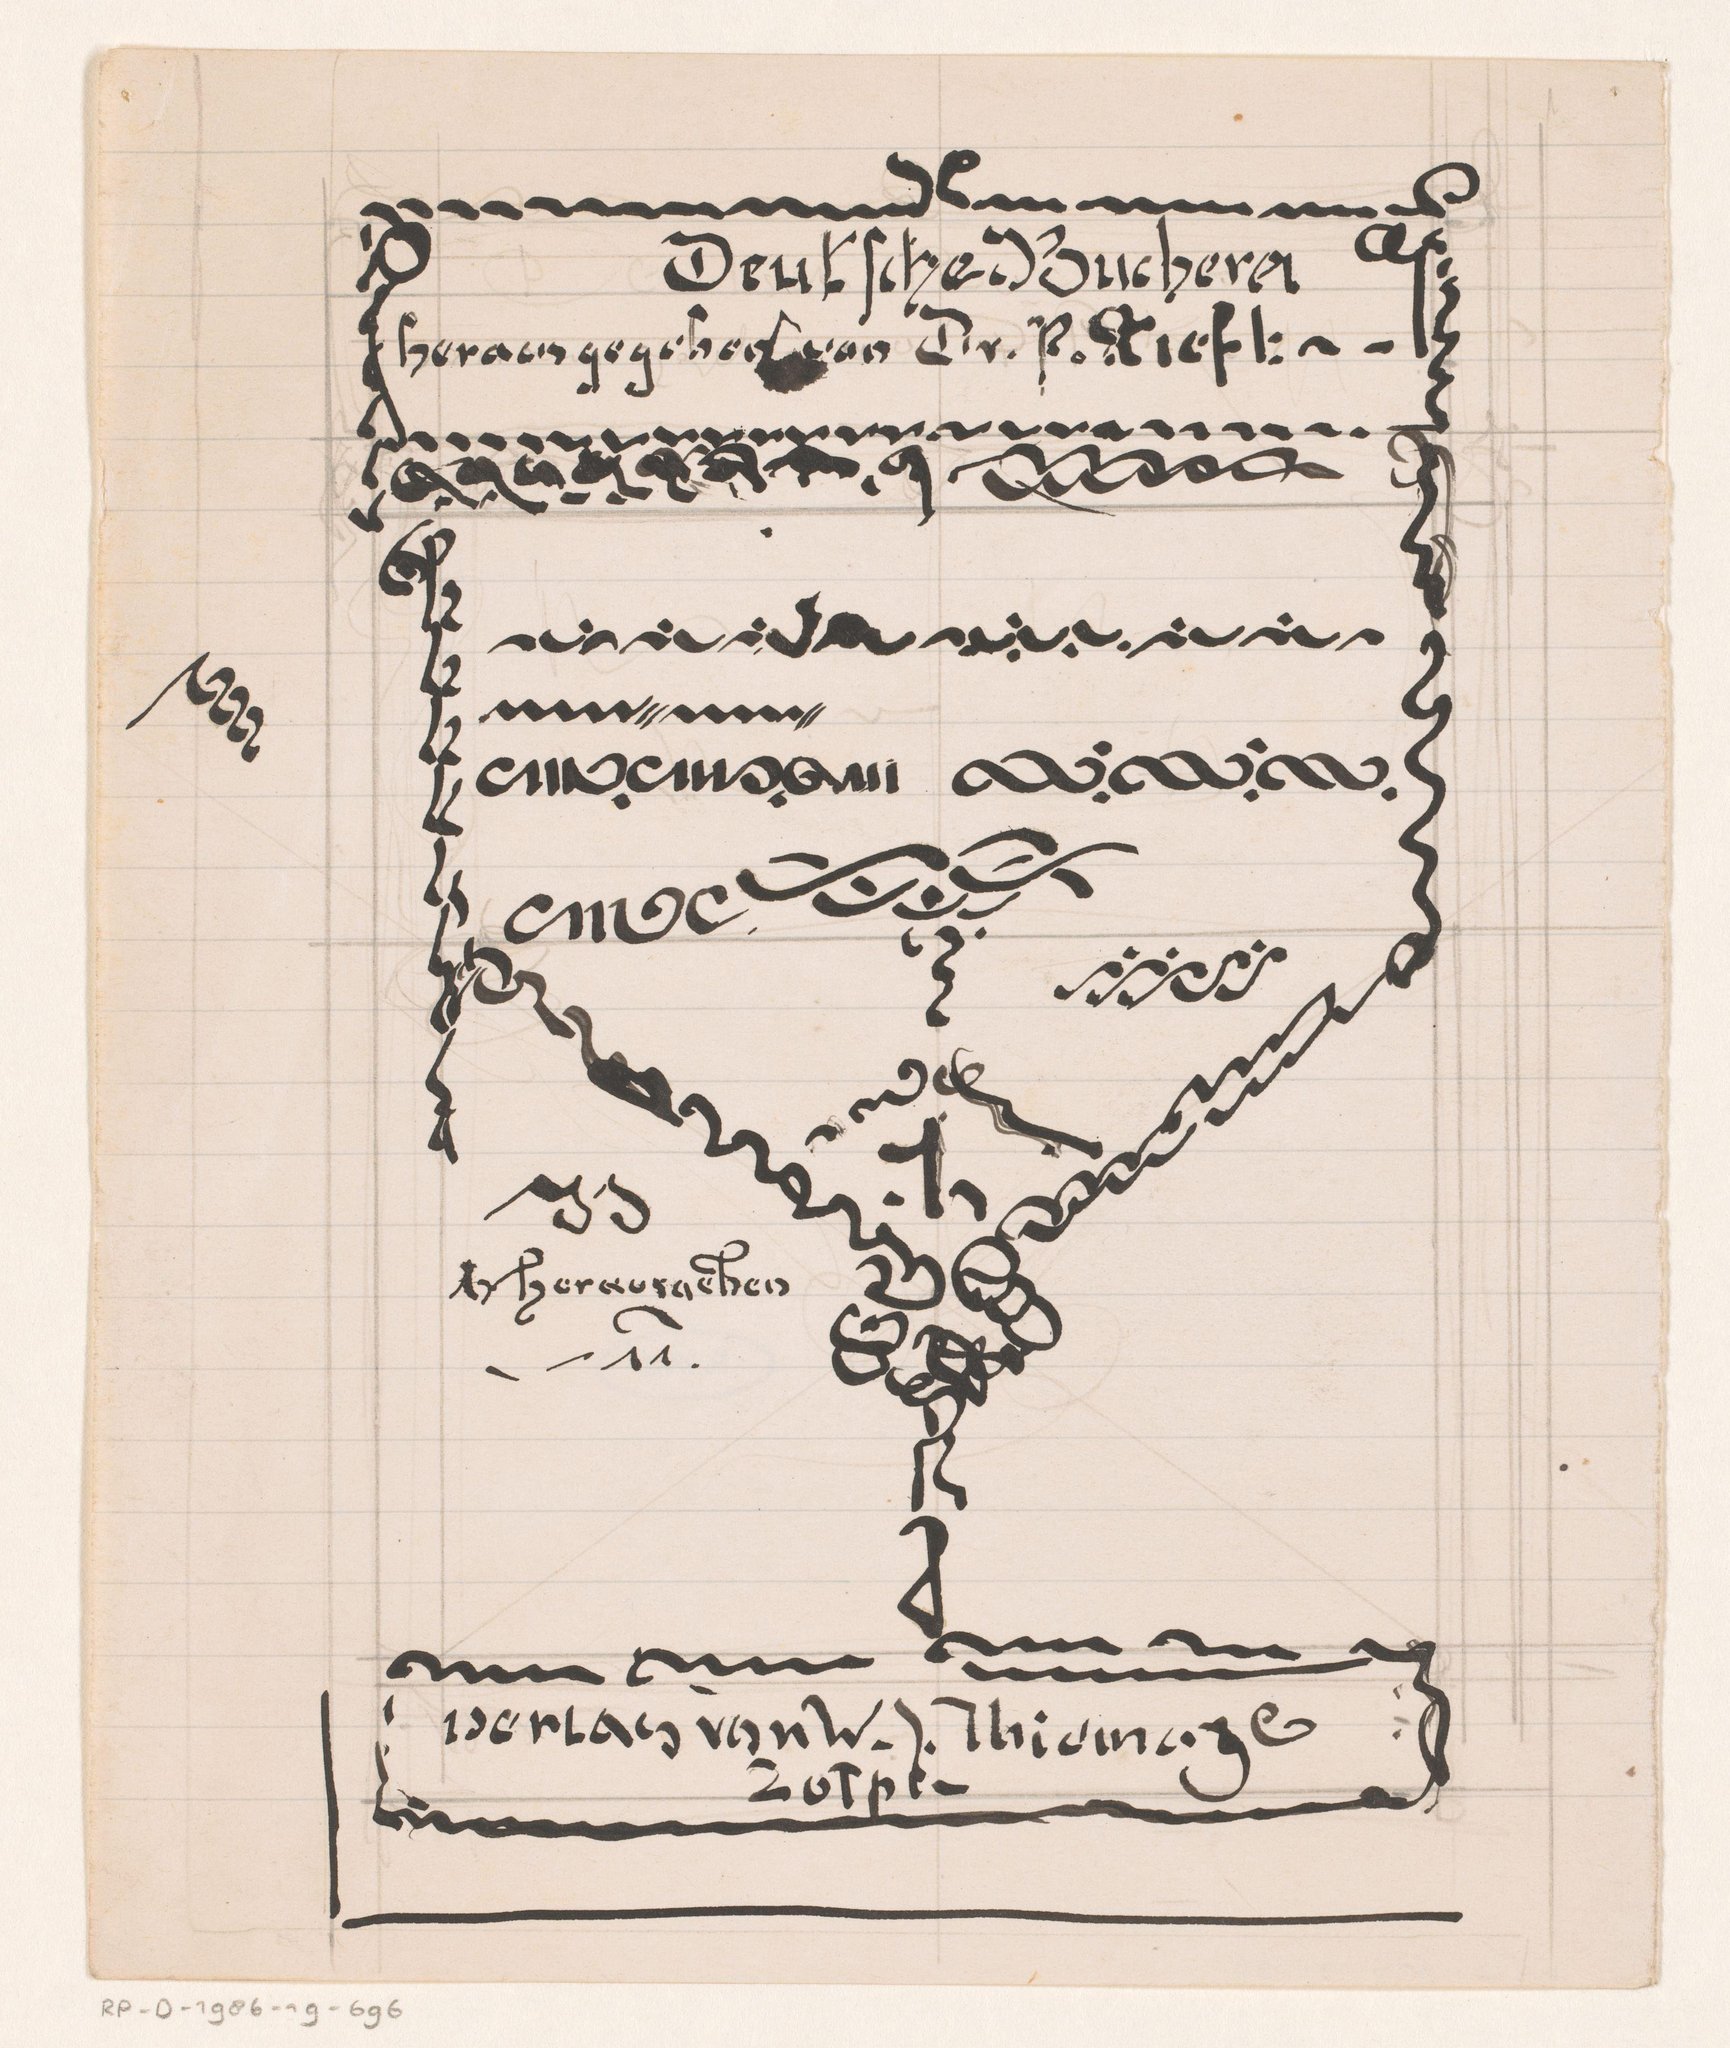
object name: drawing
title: Bandontwerp voor een boek gepubliceerd door dr. P. Kieft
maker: reinier willem petrus de vries (1874-1953)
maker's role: draughtsman, print maker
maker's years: 1874-1953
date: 1884-1952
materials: ink, pencil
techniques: brush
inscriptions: collector's mark: ‘R:MVS.’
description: Het betreft mogelijk het boek: Goethe, J.W. von. Egmont: Ein Trauerspiel. Zutphen: W.J. Thieme & Cie (Deutsche Bücherei herausgegeben von dr. P. Kieft), c. 1930. Of het ontwerp is gebruikt voor de uitgave is niet bekend.